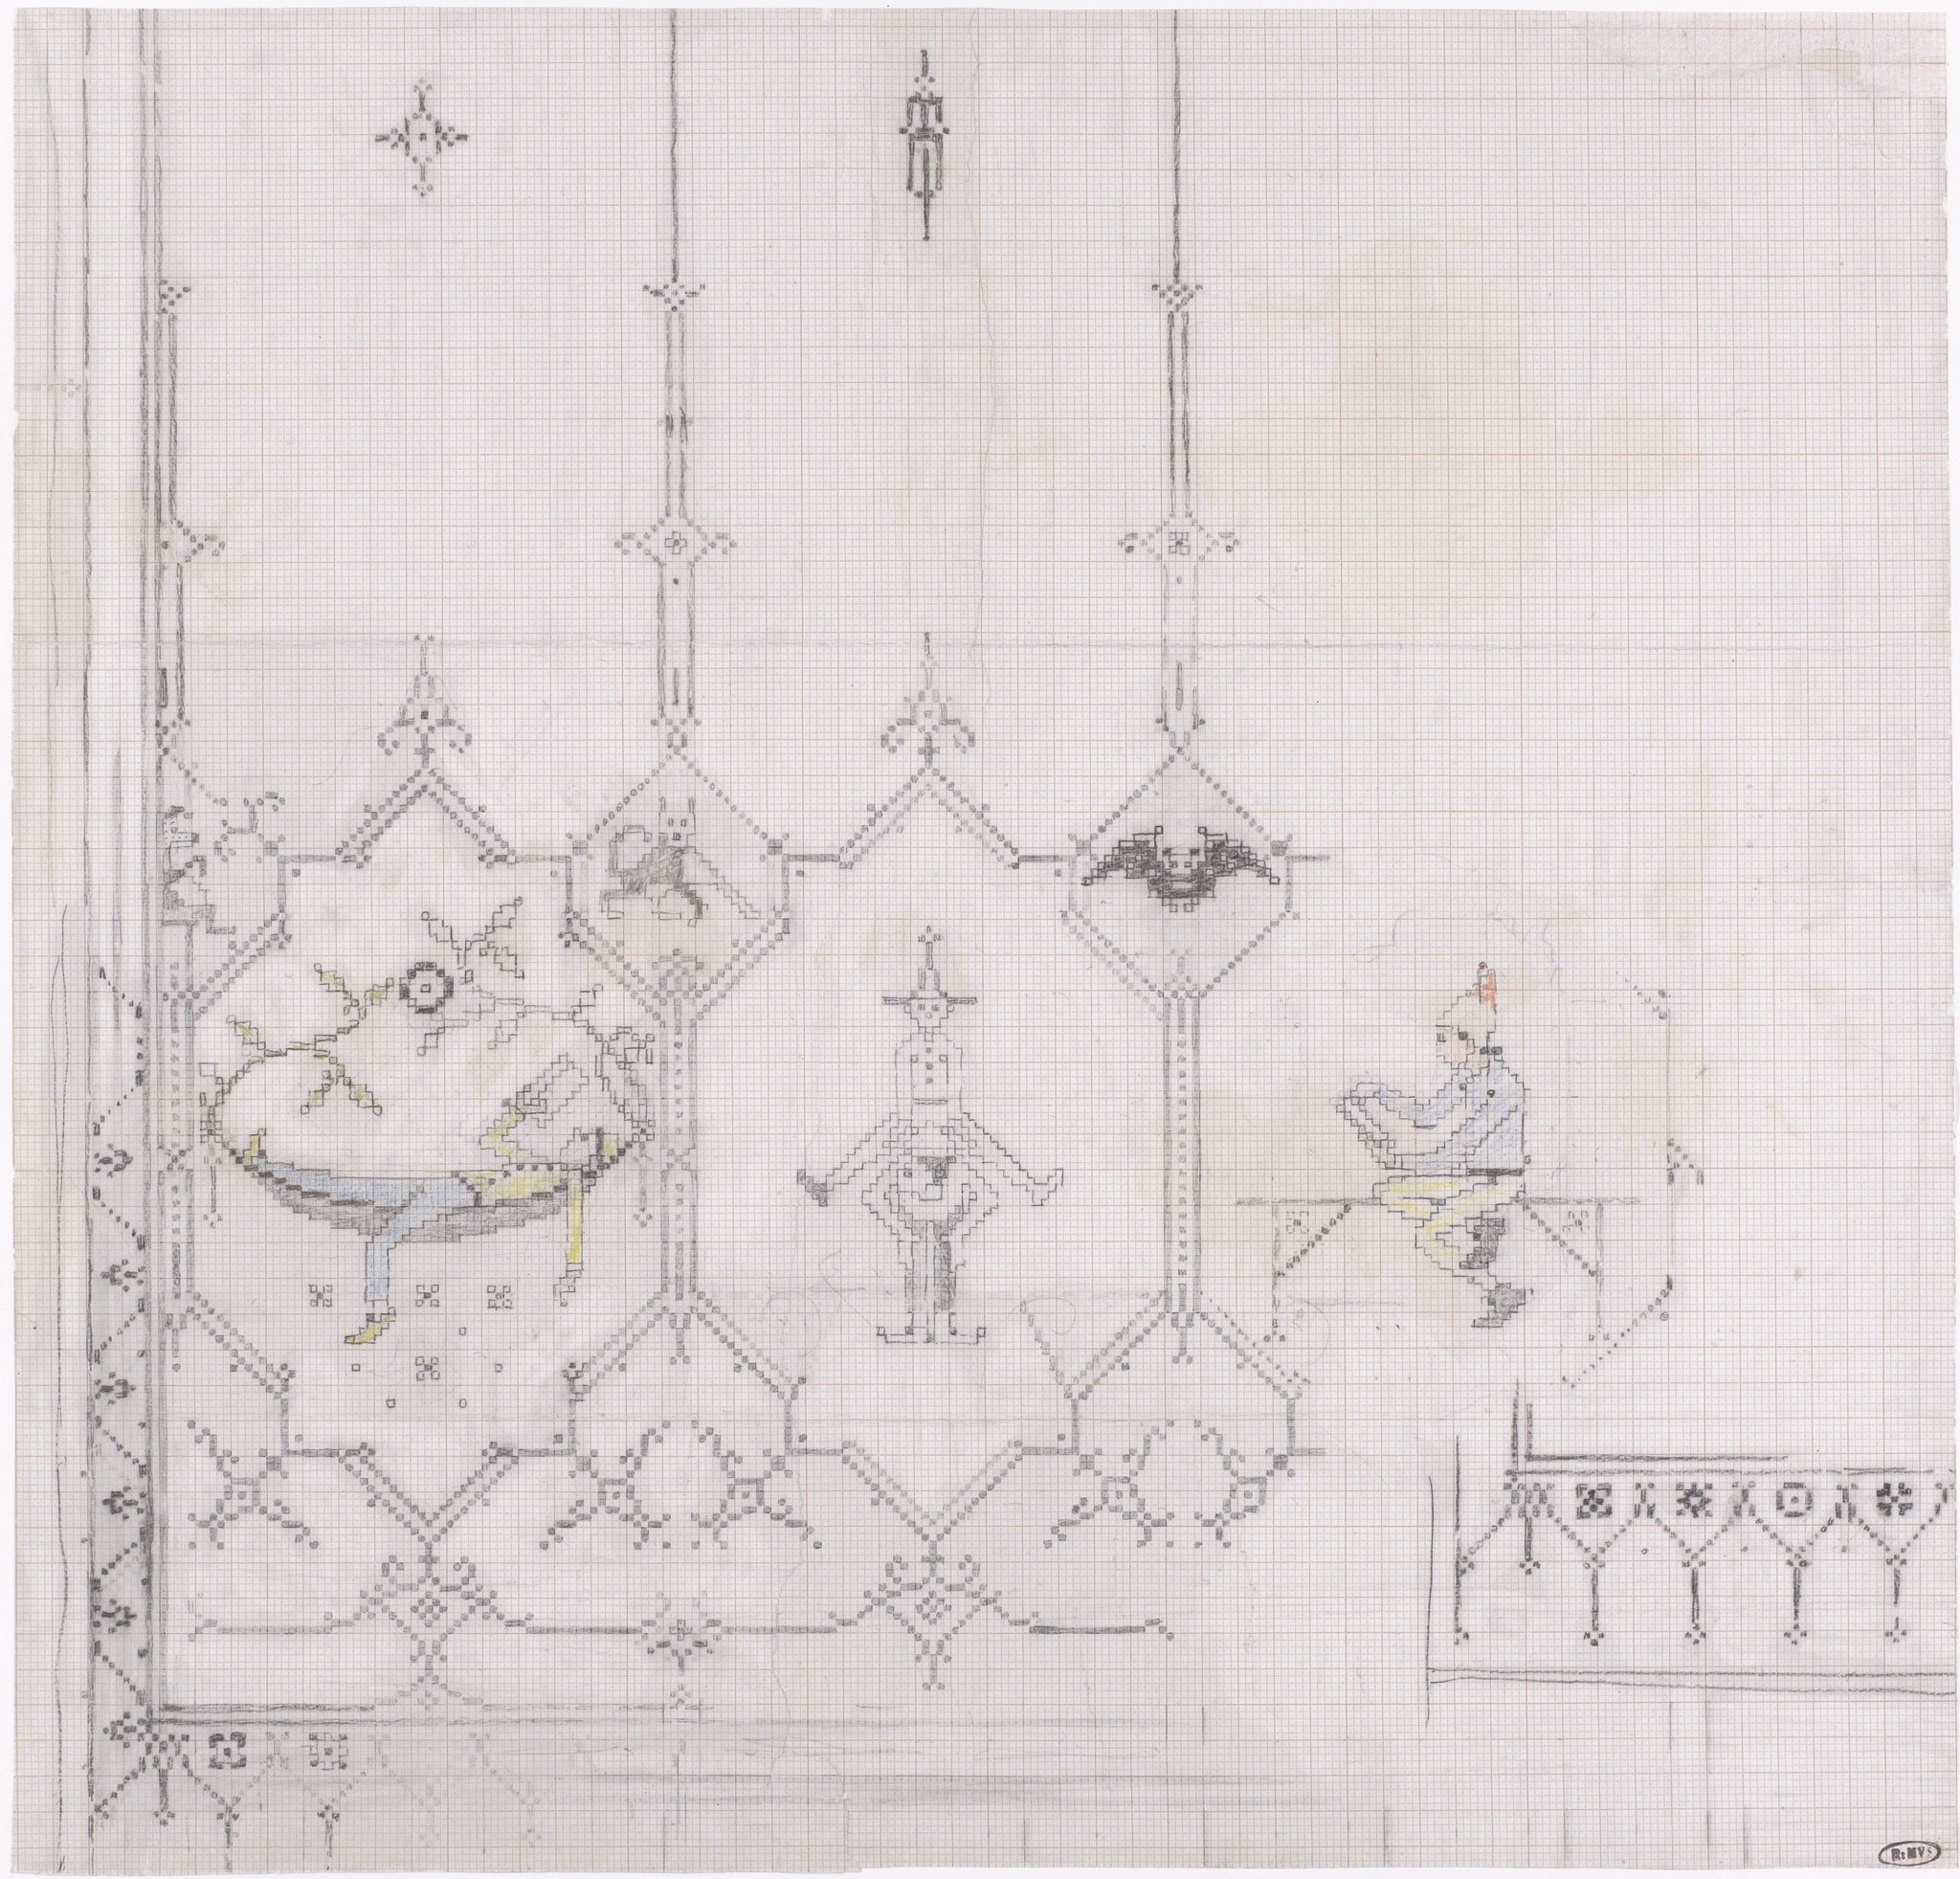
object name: drawing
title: Ontwerp voor een borduurwerk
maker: gerrit willem dijsselhof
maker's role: designer, draughtsman, print maker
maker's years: 1866-1924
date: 1876-1924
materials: chalk, pencil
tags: embroidery (ornamentation)